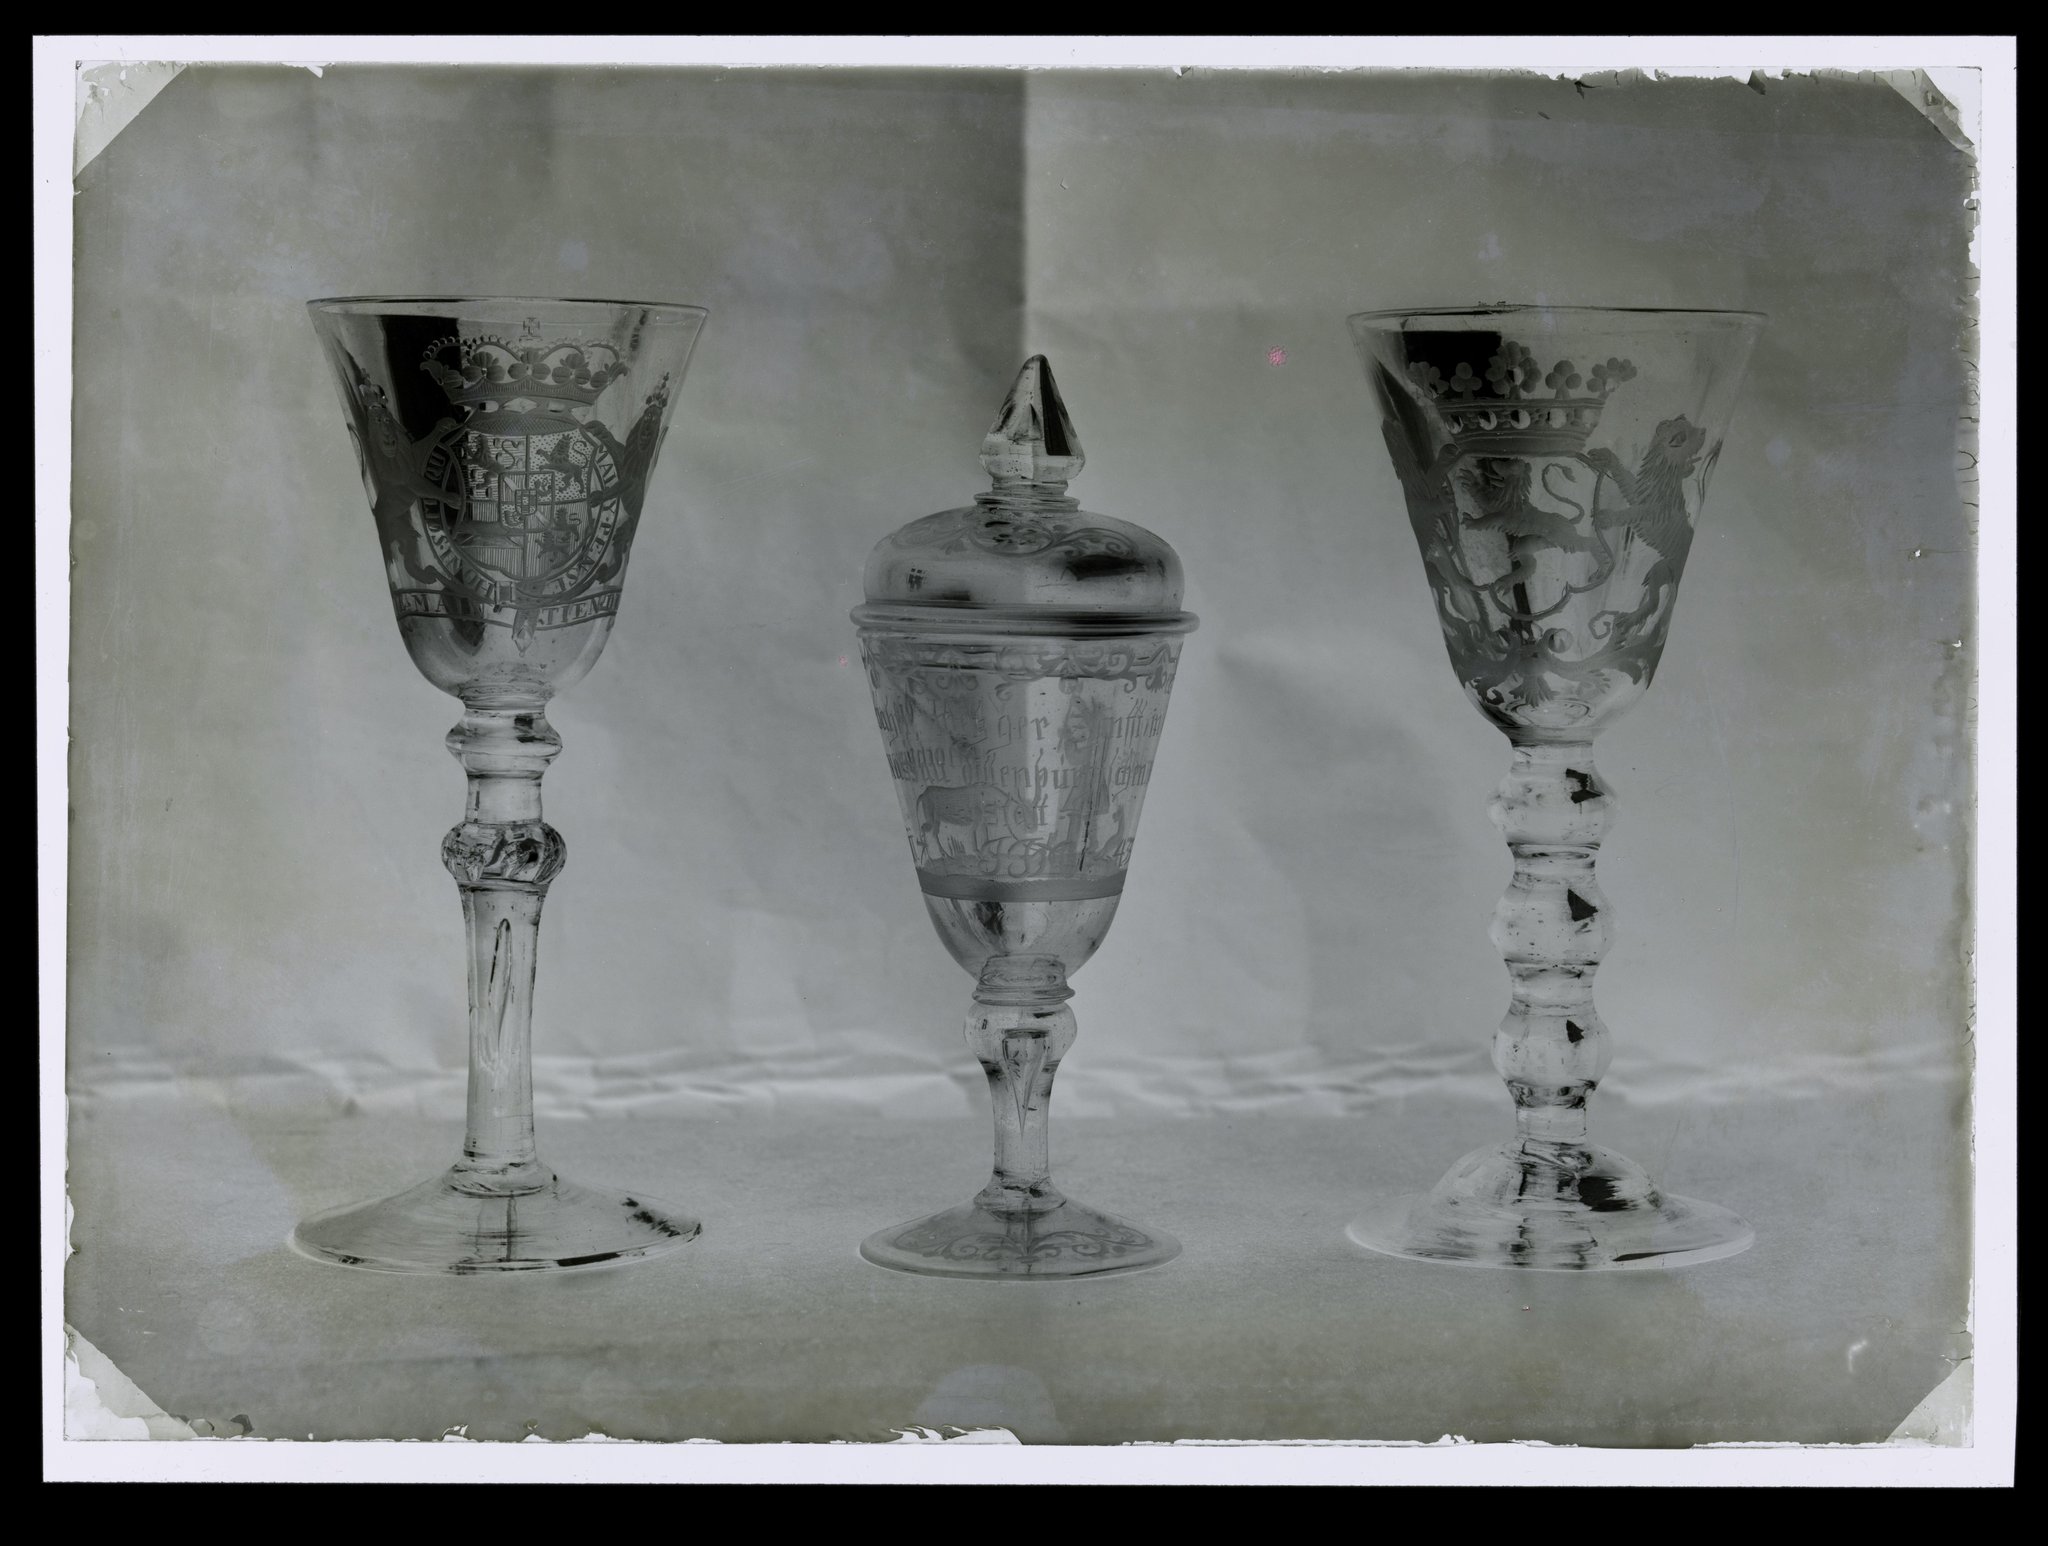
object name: glasnegatief, glasplaatnegatief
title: Drie gedecoreerde drinkglazen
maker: laurens lodewijk kleijn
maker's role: draughtsman, painter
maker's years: 1826-1909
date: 1865-1900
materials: glass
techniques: collodion process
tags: glass, rummer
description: Onderdeel van een groep glasnegatieven uit de nalatenschap van de schilder Laurens Lodewijk Kleijn, met stillevens, portretten, zelfportretten en kunstreproducties.